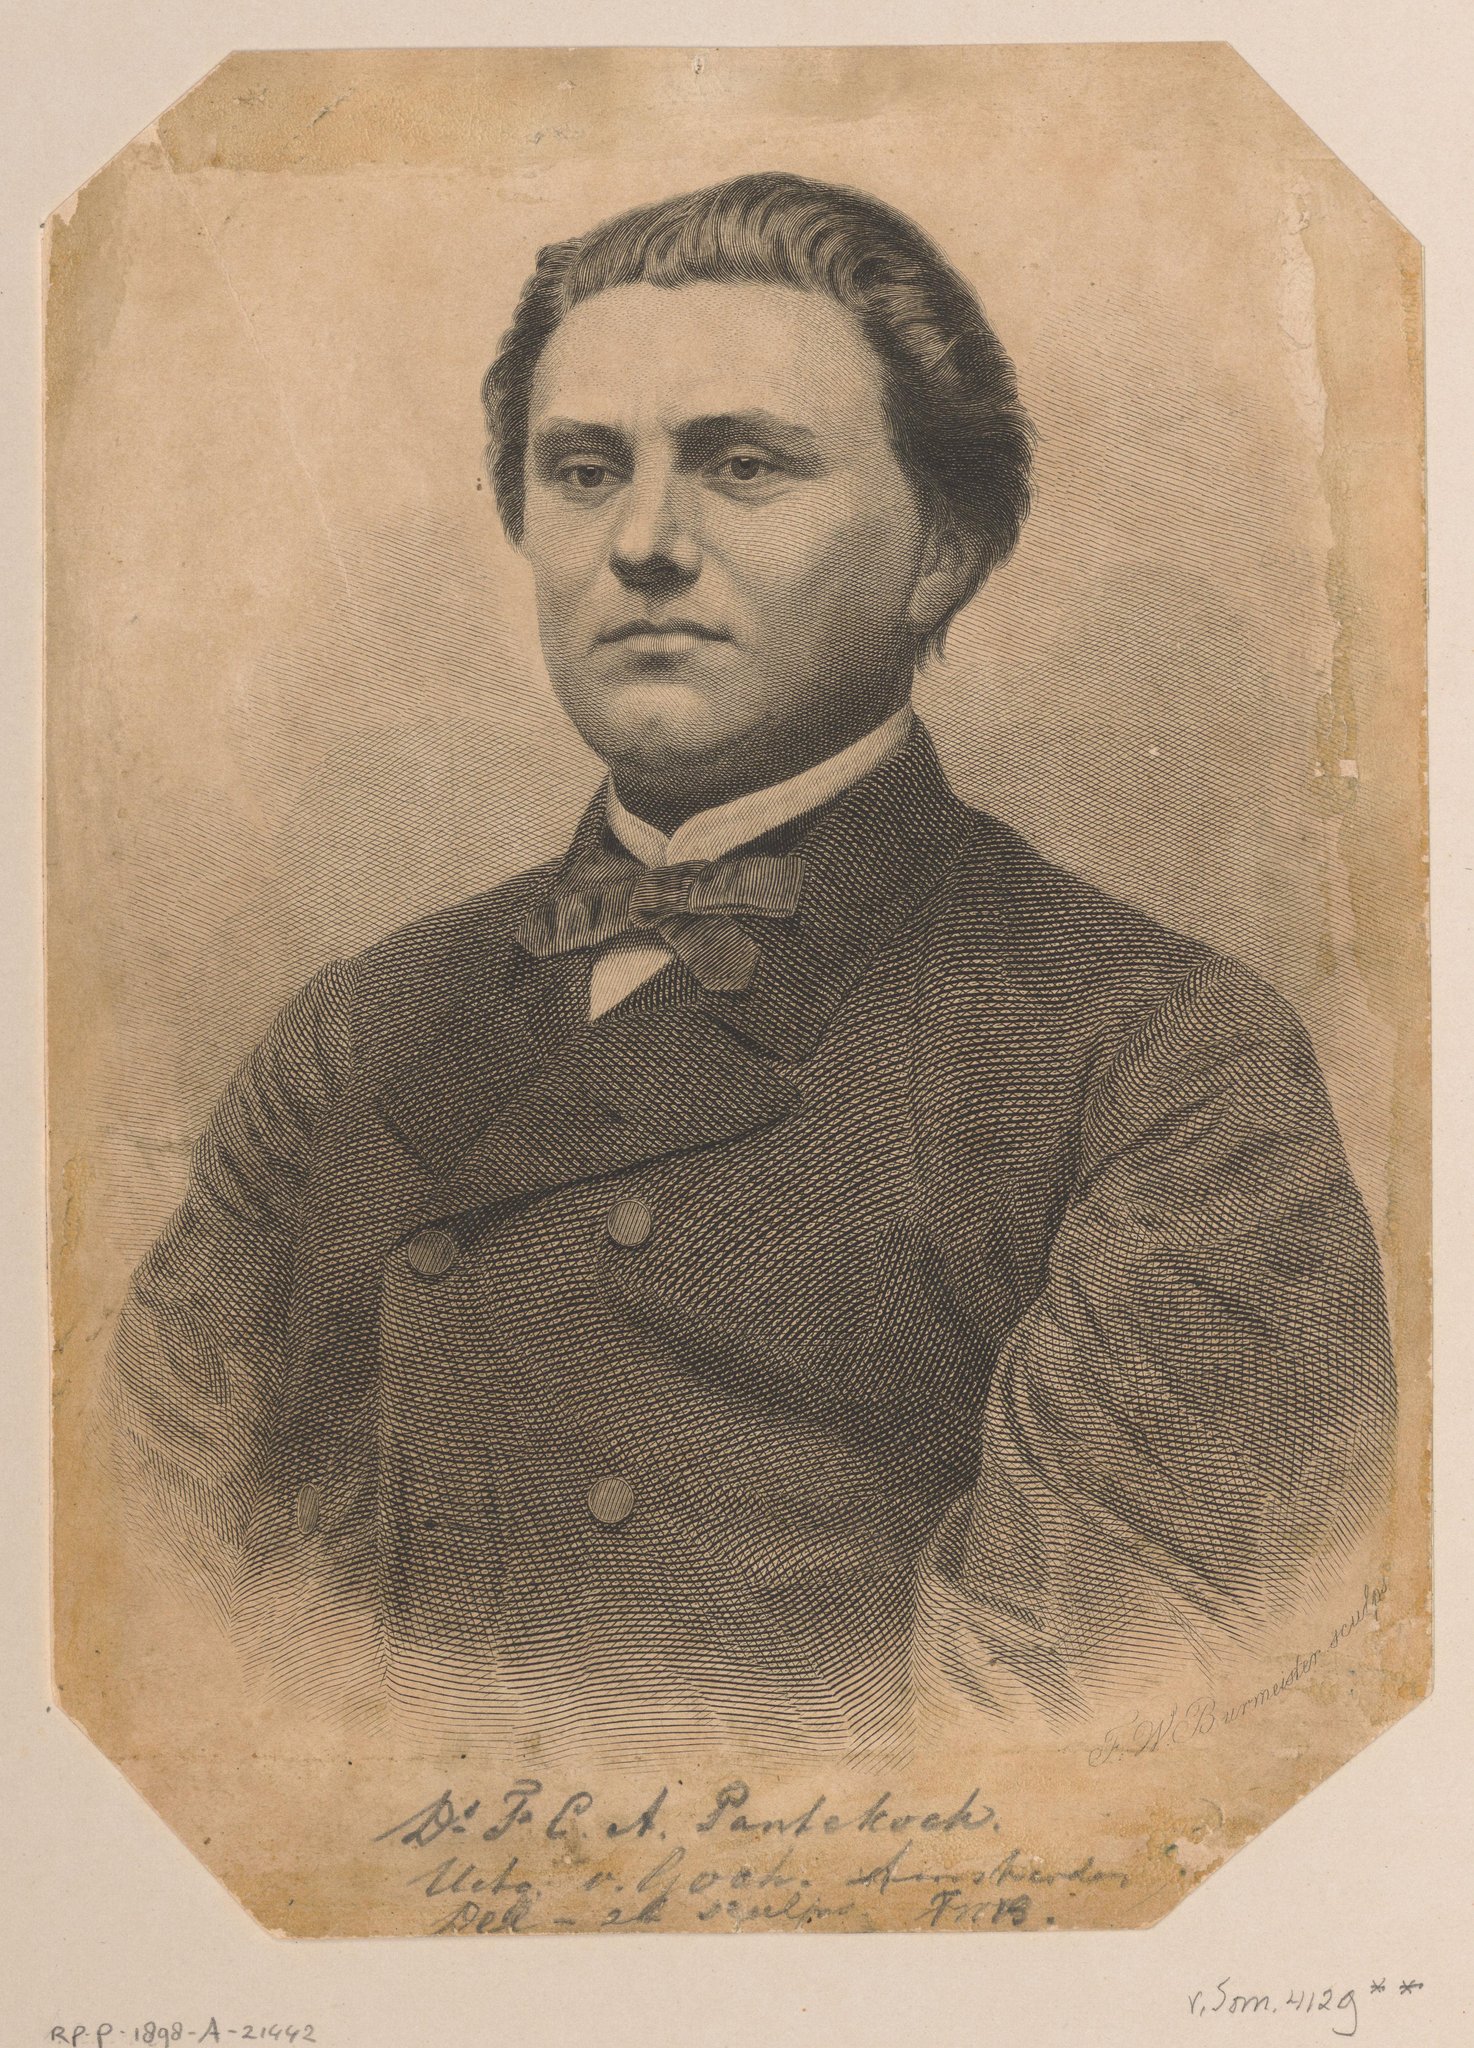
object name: print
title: Portret van Frederik Karel Antonius Pantekoek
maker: friedrich wilhelm burmeister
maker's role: print maker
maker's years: 1845-1933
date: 1855-1898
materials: paper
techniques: letterpress printing, engraving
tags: adult man, historical persons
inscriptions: collector's mark: Lugt 964